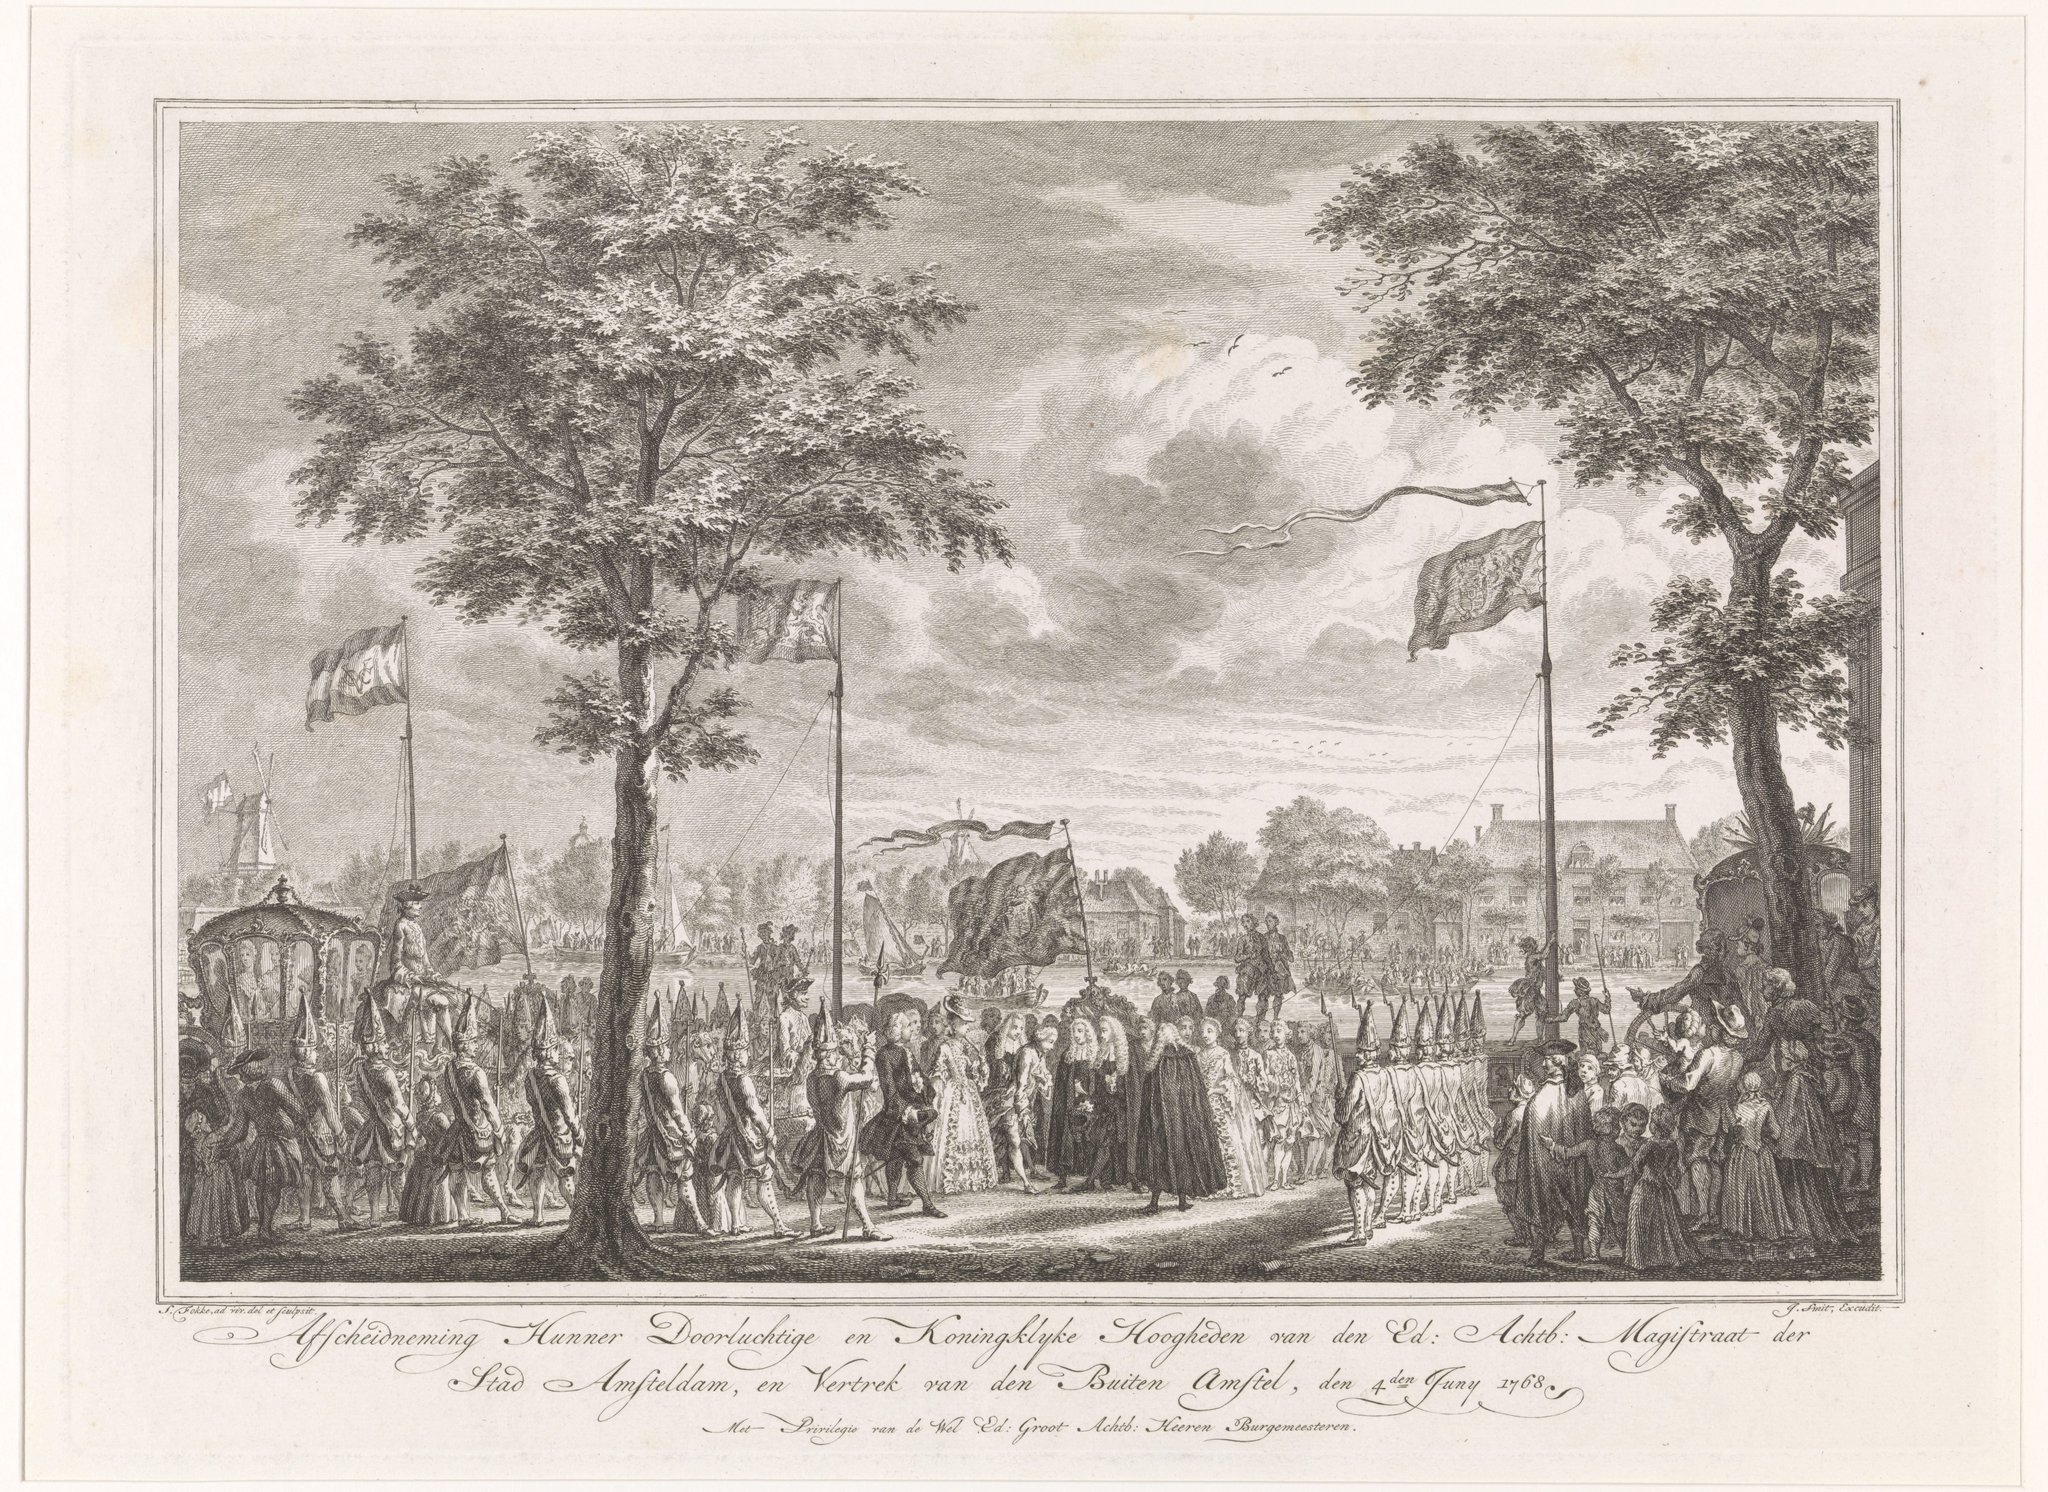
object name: print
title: Afscheidneming Hunner Doorluchtige en Koningklyke Hoogheden van den Ed: Achtb: Magistraat der Stad Amsteldam, en Vertrek van den Buiten Amstel, den 4den Juny 1768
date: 1769-1773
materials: paper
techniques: engraving, etching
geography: northern netherlands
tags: the hague, william v (prince of orange), berlin, painter, draughtsman, wilhelmina of prussia (princess of orange), public festivities on the occasion of royal events, amsterdam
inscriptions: collector's mark: Lugt 2228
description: De stadhouder Willem V en prinses Wilhelmina van Pruisen nemen afscheid van het magistraat van Amsterdam bij de herberg De Berebijt aan de Buitenamstel, 4 juni 1768. Onderdeel van een prentserie met titelprent en 14 platen van de inhaling van de prins en prinses te Amsterdam, 30 mei - 4 juni 1768.